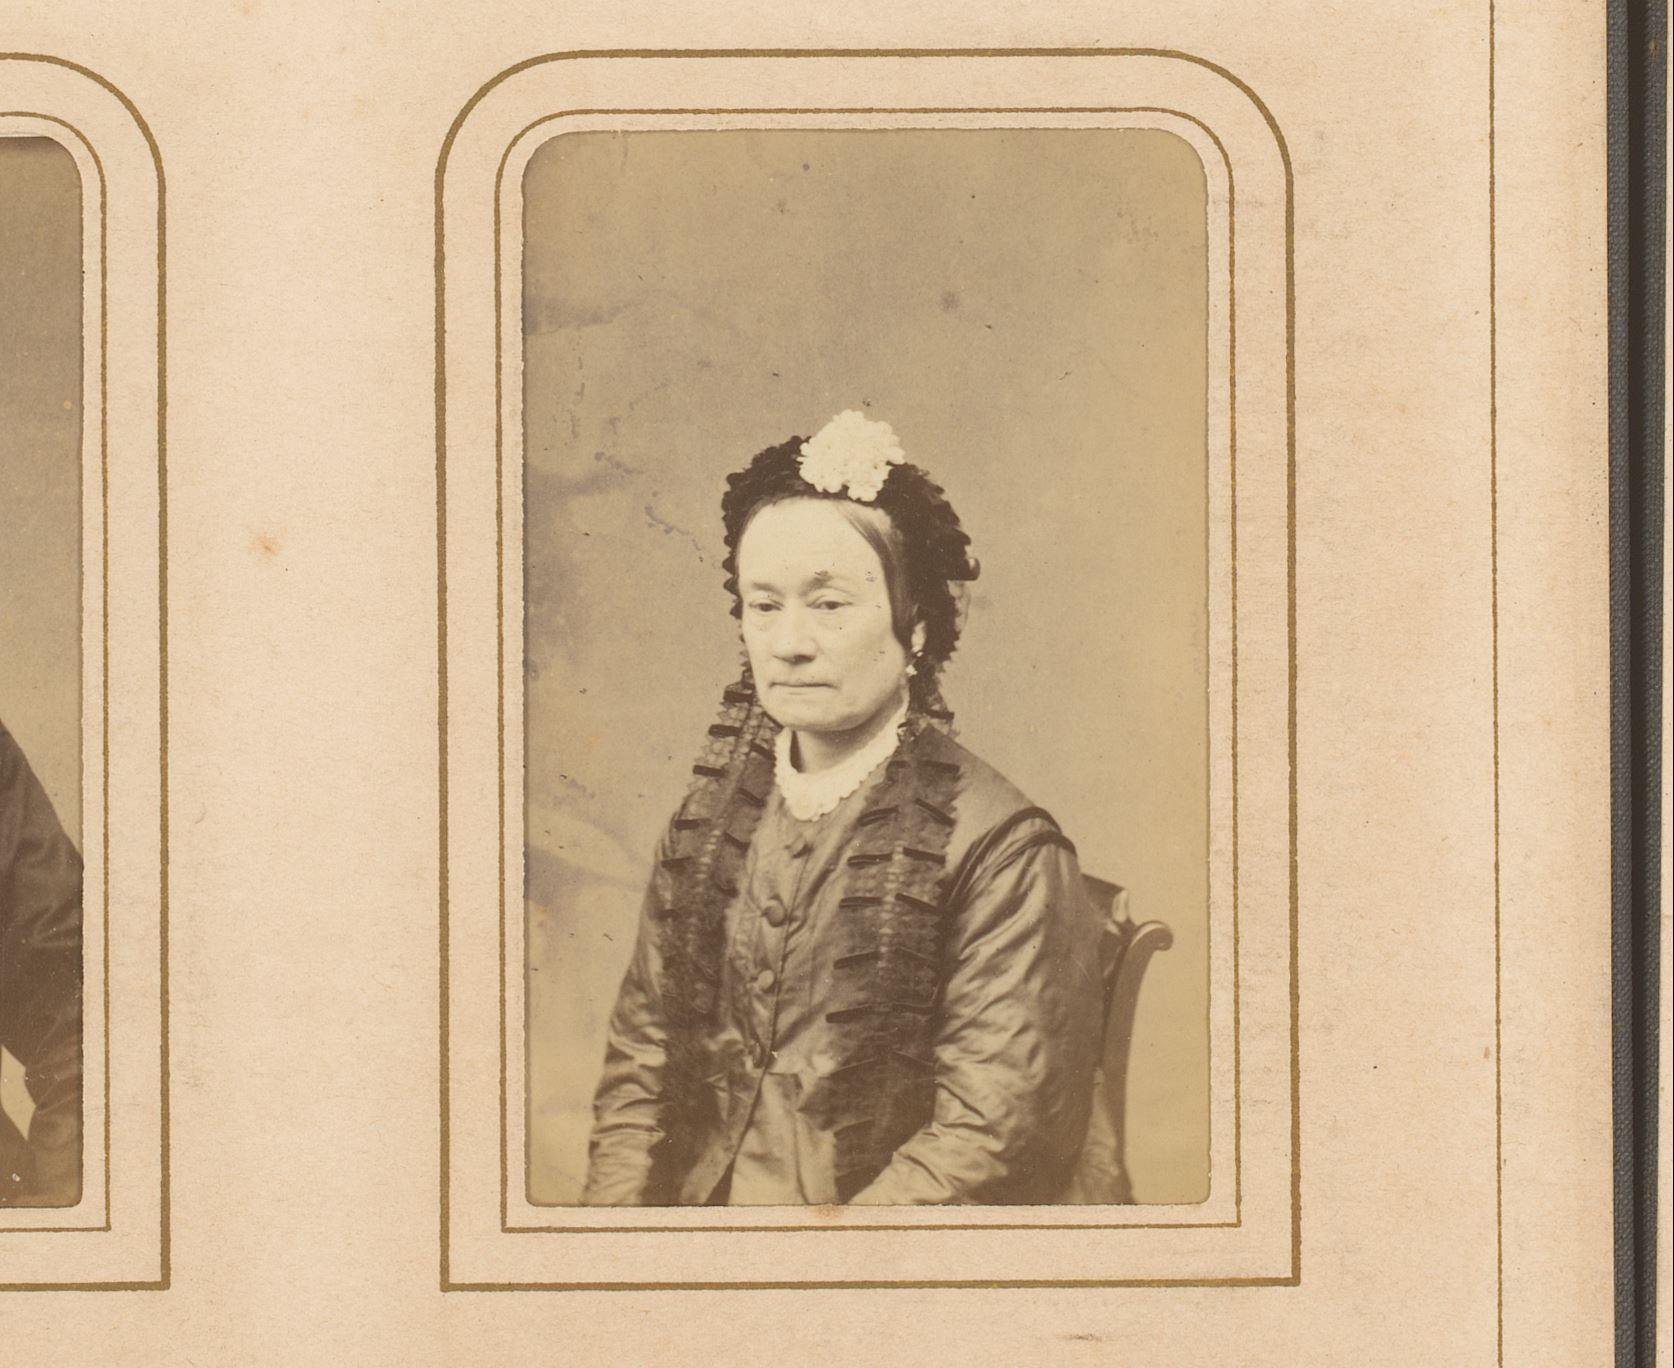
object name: photograph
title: Portret van een zittende vrouw met muts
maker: prosper bevierre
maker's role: fotograaf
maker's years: 1822-1893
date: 1850-1893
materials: cardboard, photographic support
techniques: albumen print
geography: charleroi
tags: sitting figure - aa - female human figure, historical persons - bb - woman, head-gear: cap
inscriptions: inscription: ‘PHOTOGRAPHIE/ DE/ Prosper BEVIERRE/ 3, Rue de la Montagne, 3/ CHARLEROI/ (...)’